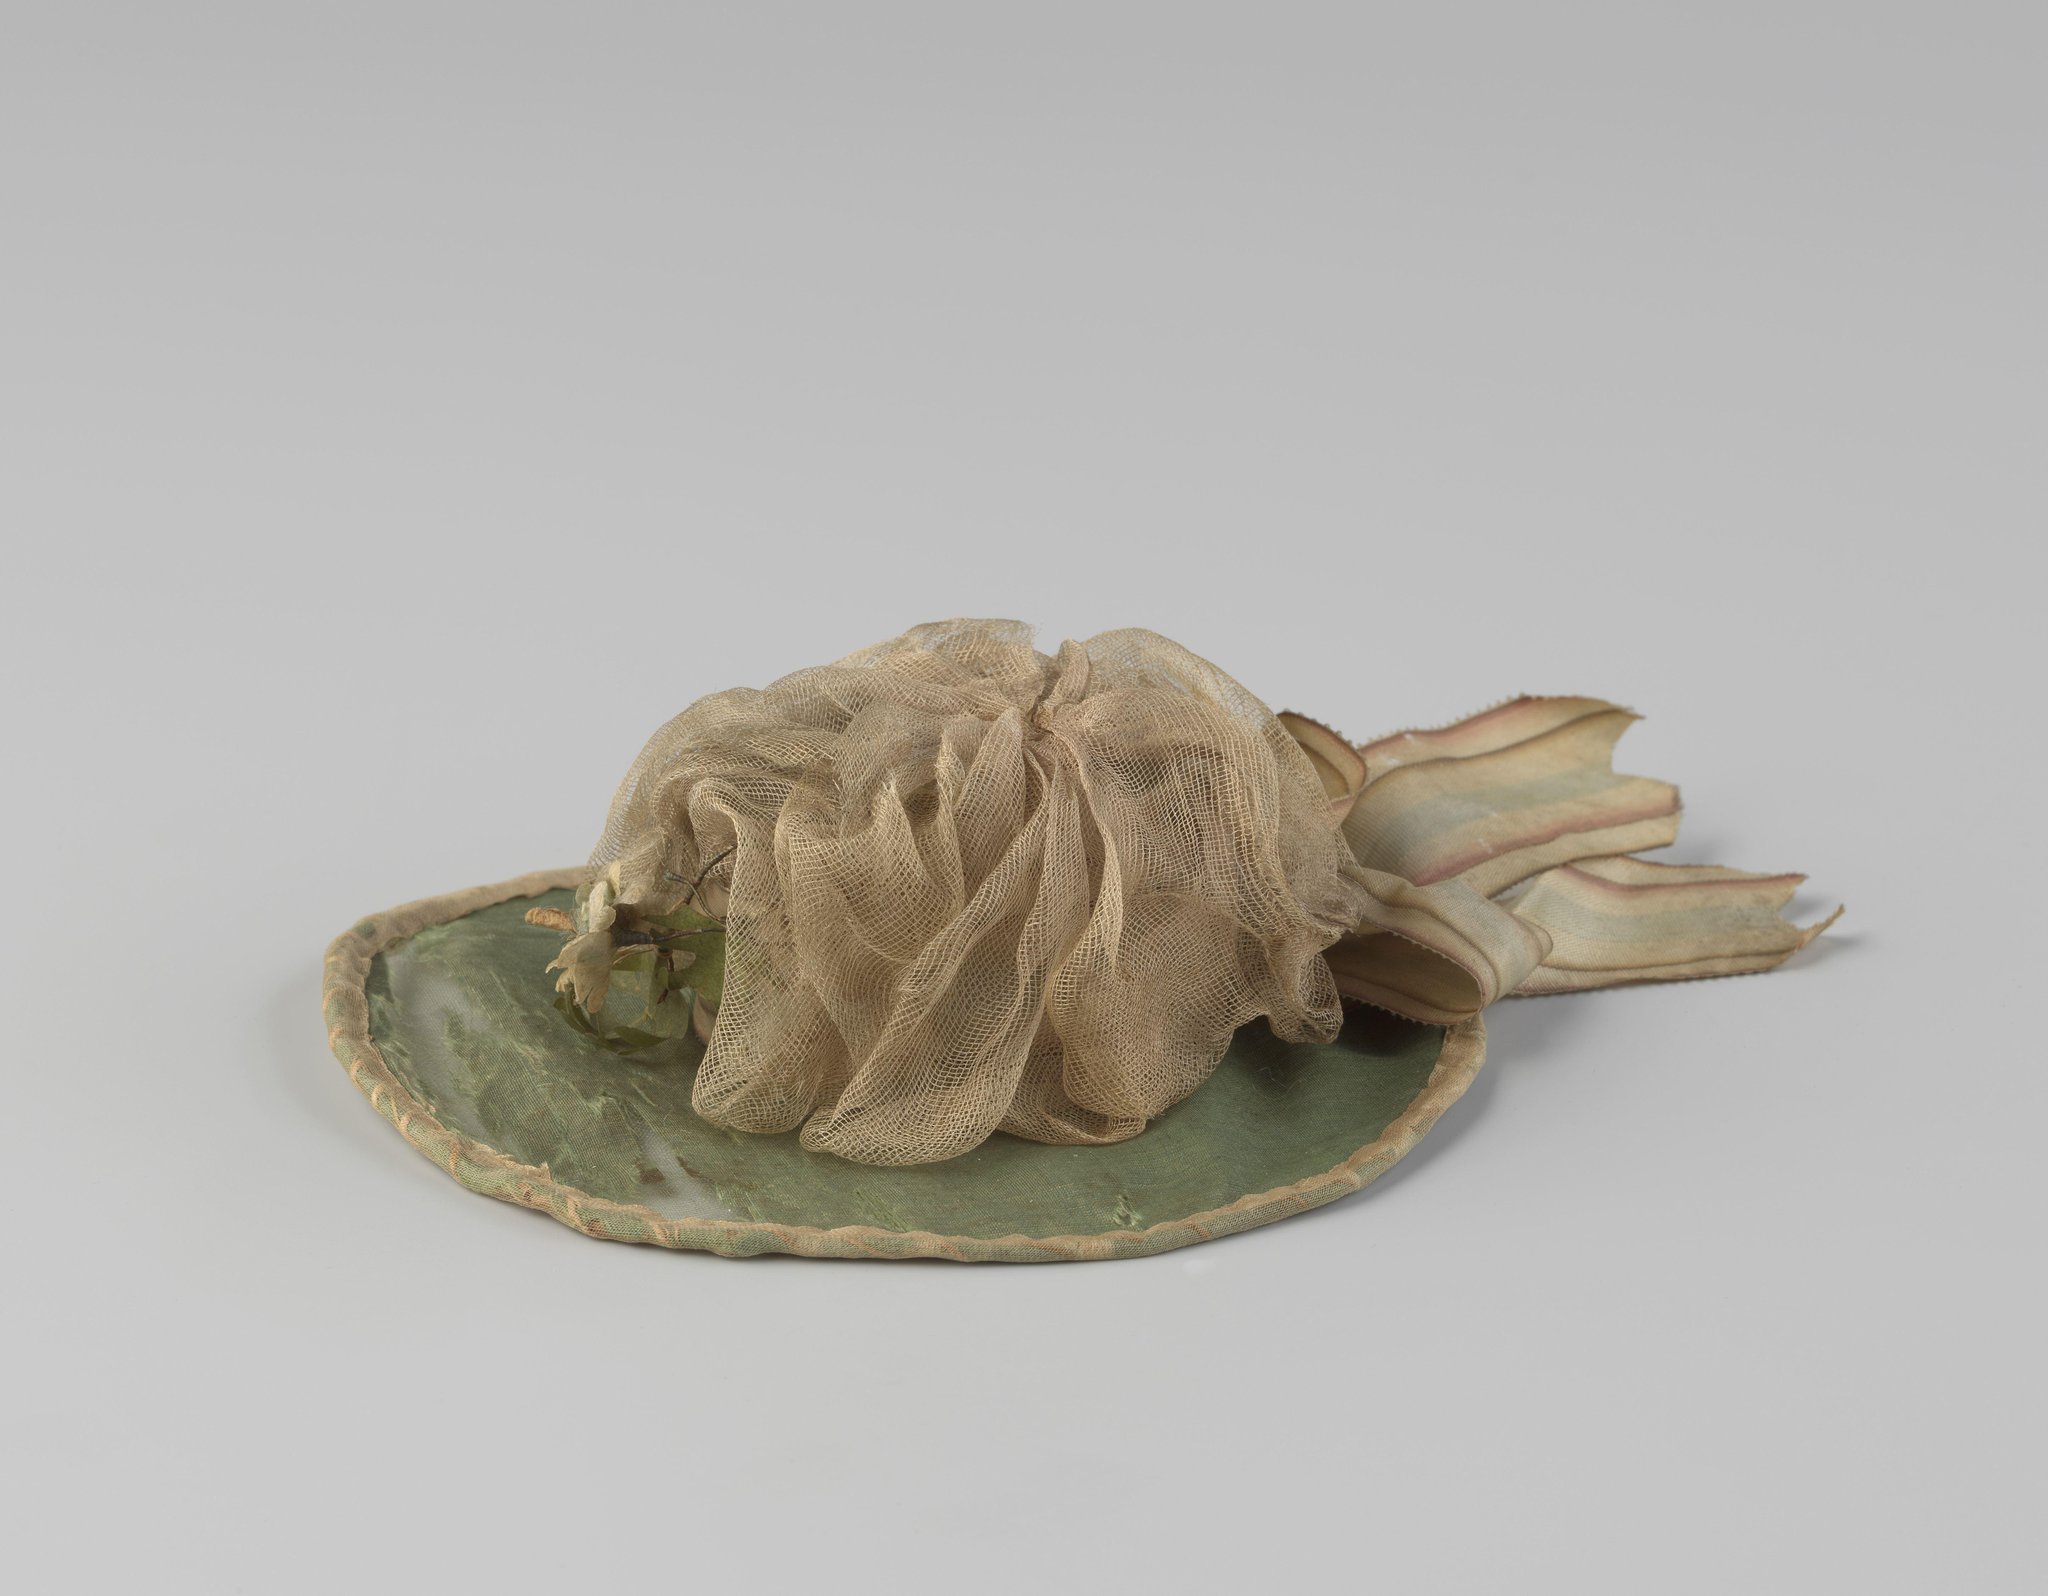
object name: hat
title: Hoed van groene zijde, tule en gestreept lint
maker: Anonymous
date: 1800-1900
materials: silk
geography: europe